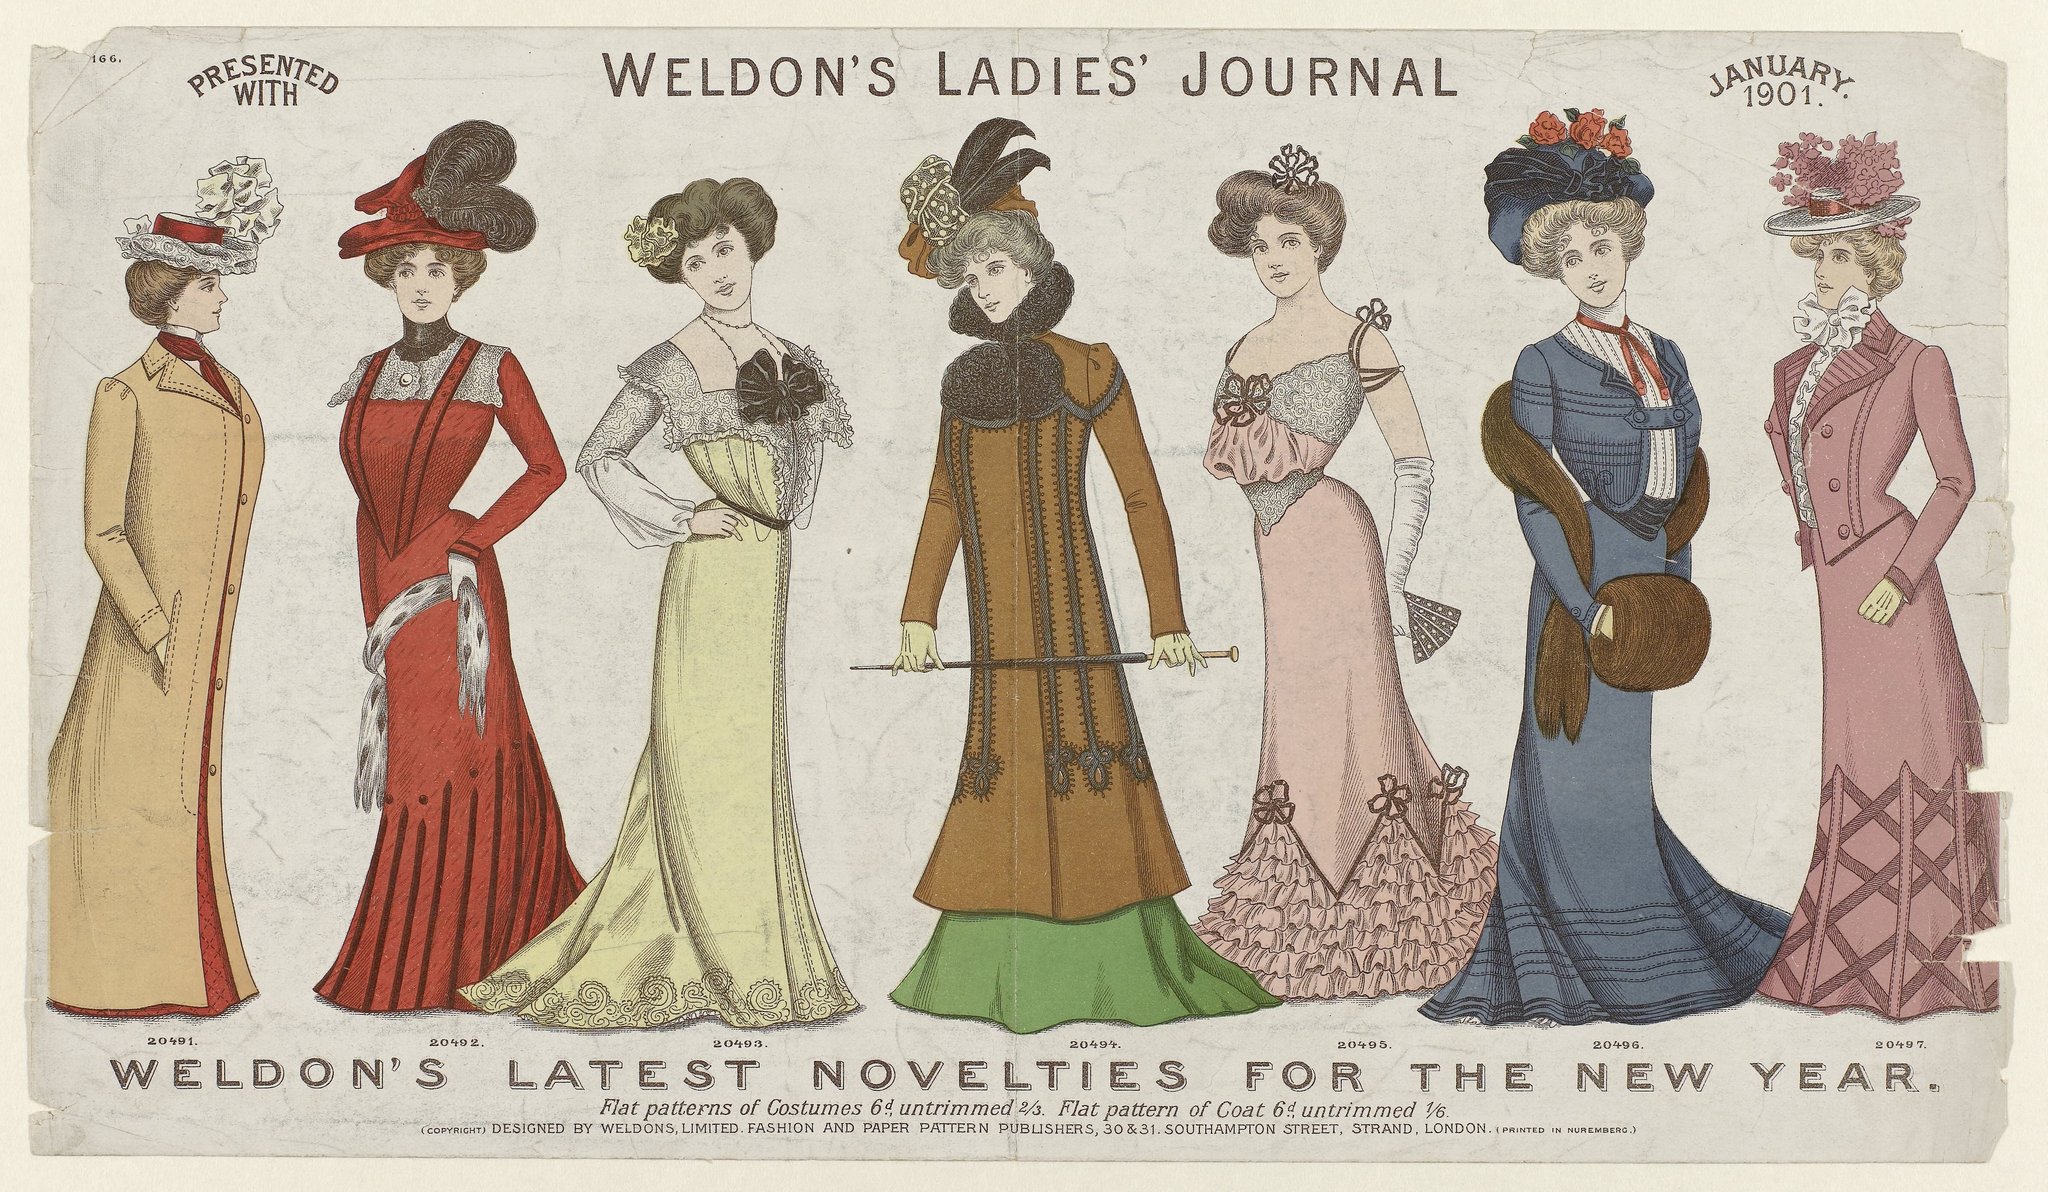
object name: fashion print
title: Weldon's Ladies'Journal, january 1901, No. 166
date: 1901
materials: paper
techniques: engraving, hand coloring, letterpress printing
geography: nuremberg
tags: dress, gown: evening dress (+ women's clothes), clothing for the upper part of the body (stola) (+ fur used for clothes), coat (+ women's clothes), fashion plates, head-gear: hat (+ women's clothes), dress, gown (+ women's clothes), fan (+ women's clothes), muff (+ fur used for clothes)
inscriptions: title: ‘PRESENTED WITH WELDON´S LADIES´JOURNAL JANUARY 1901.’, address: ‘(COPYRIGHT) DESIGNED BY WELDONS, LIMITED. FASHION AND PAPER PATTERN PUBLISHERS, 30&31. SOUTHAMPTON STREET, STRAND, LONDON, (PRINTED IN NUREMBERG.)’, caption: ‘20491. 20492. 20493. 20494. 20495. 20496. 20497. / WELDON´S LATEST NOVELTIES FOR THE NEW YEAR. / Flat patterns of Costumes 6 d each untrimmed 2/3, Flat pattern of Coat 6d untrimmed 1/6.’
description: Prent uit het modetijdschrift Weldon's Ladies' Journal (1875–1954).